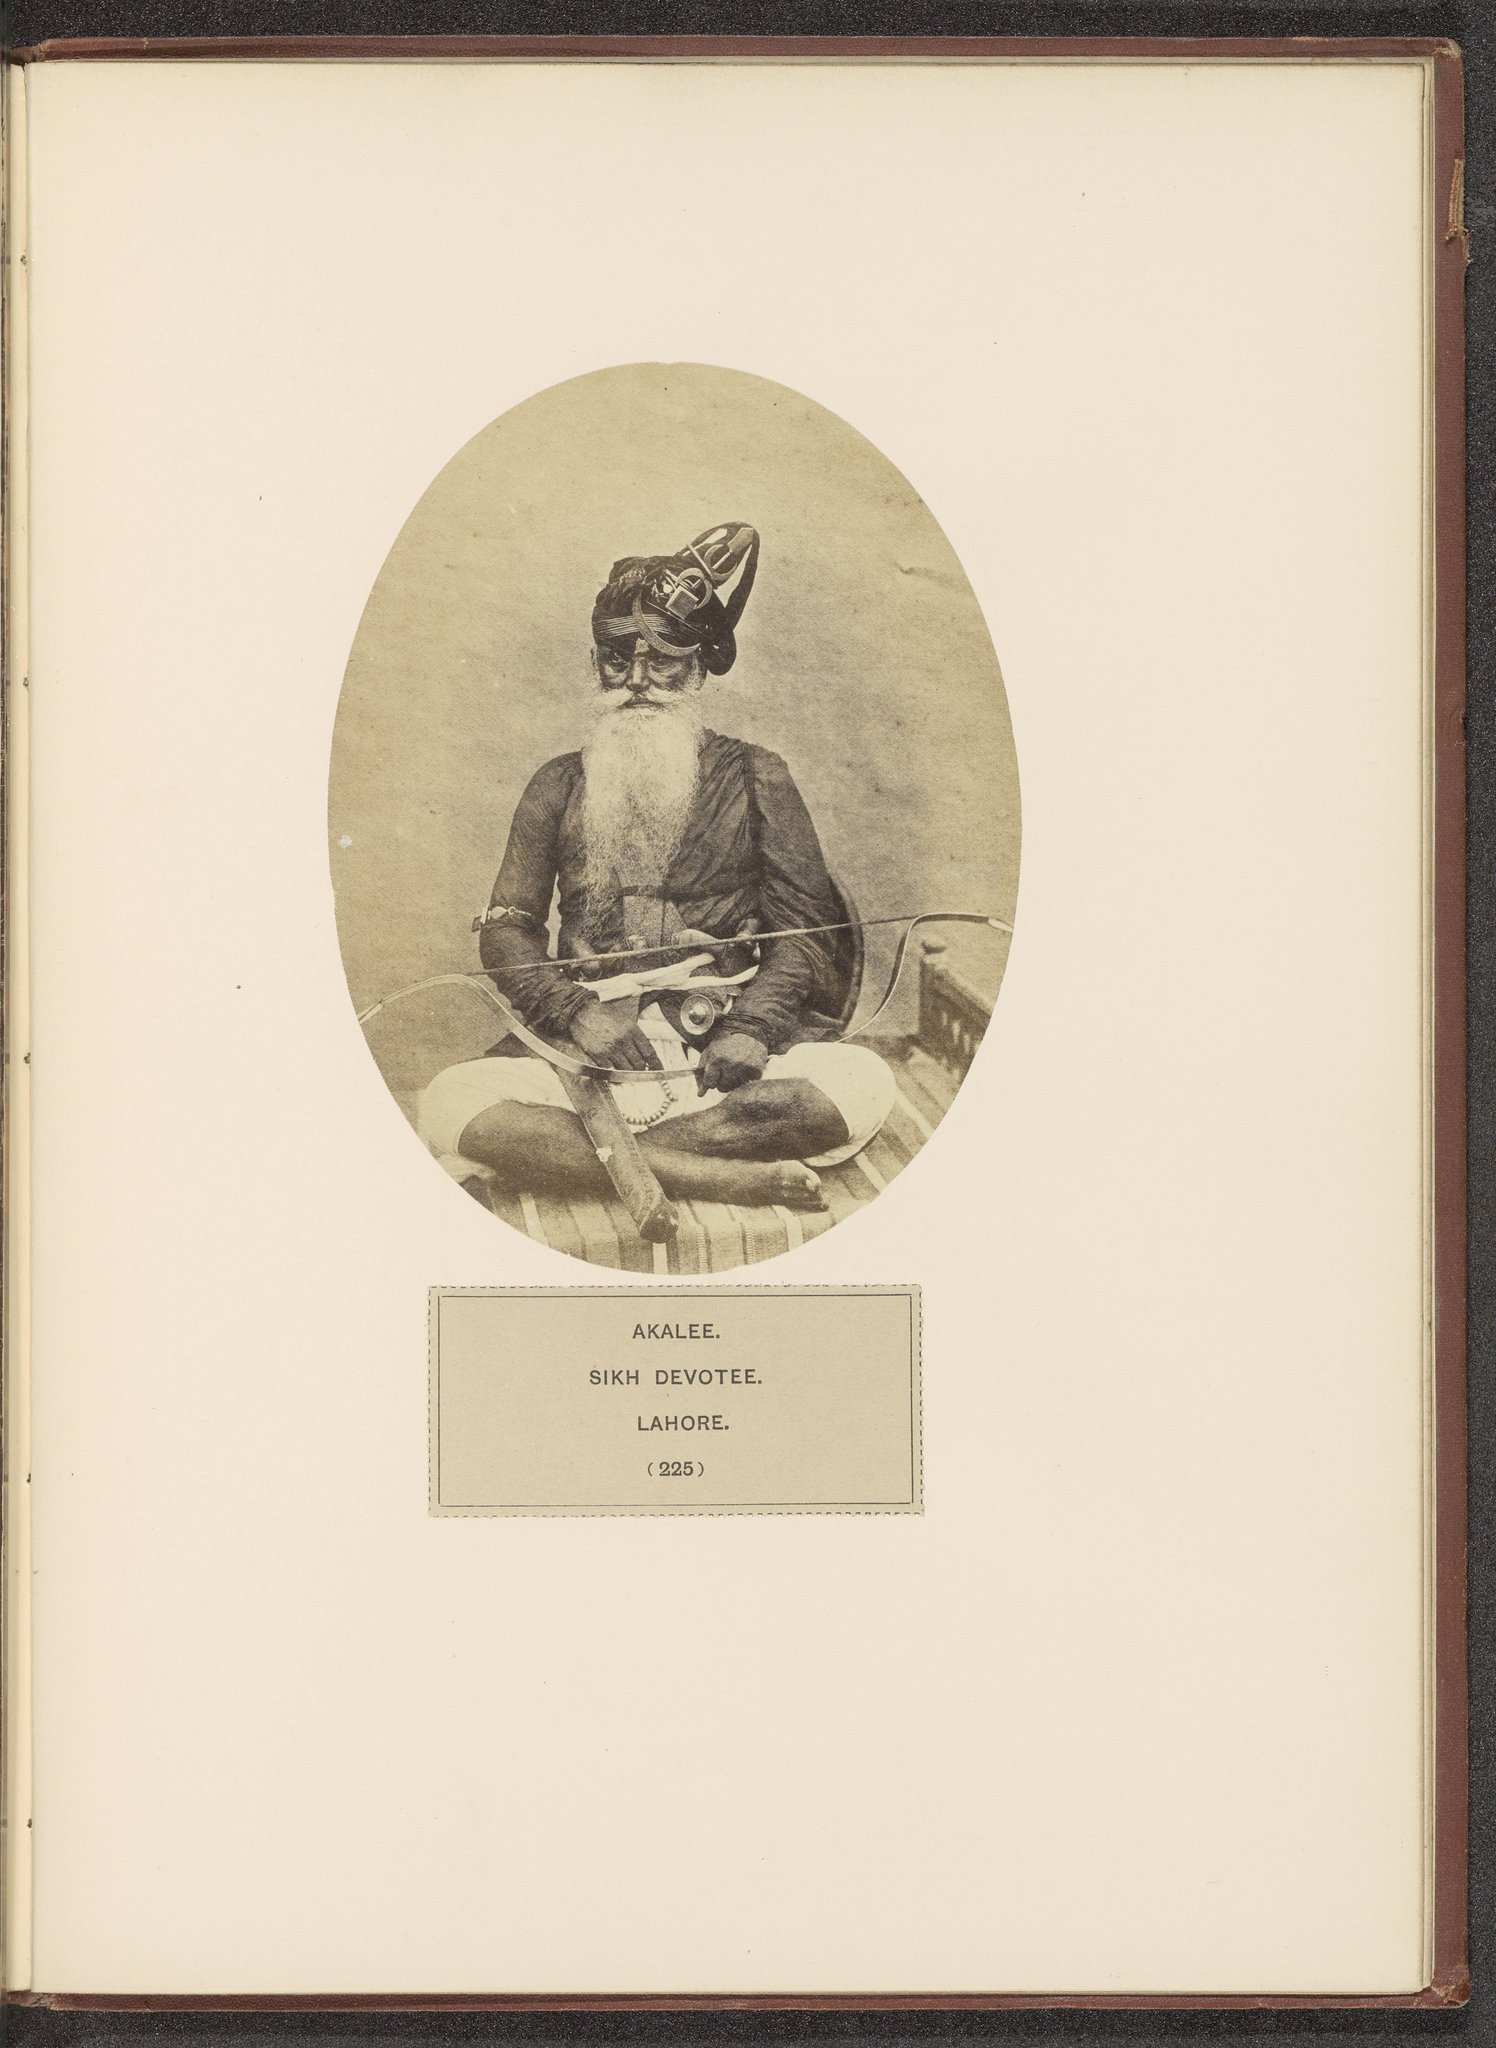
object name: photograph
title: Portrait of an unknown mendicant with a bow from the Akali community of Lahore, Punjab, Pakistan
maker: Anonymous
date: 1859-1869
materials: photographic support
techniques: albumen print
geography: lahore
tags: archer's weapons: bow, human races; peoples; nationalities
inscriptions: inscription: ‘AKALEE./ SIKH DEVOTEE./ LAHORE.’, number: ‘(225)’